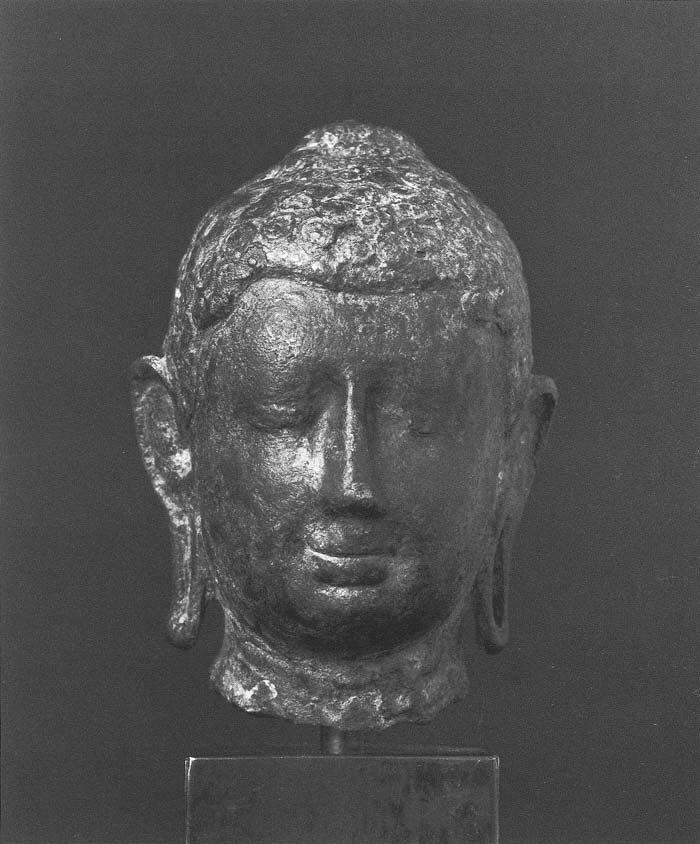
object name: head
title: Head of a Buddha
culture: sri lankan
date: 401-500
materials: bronze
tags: heads,buddhism,buddha